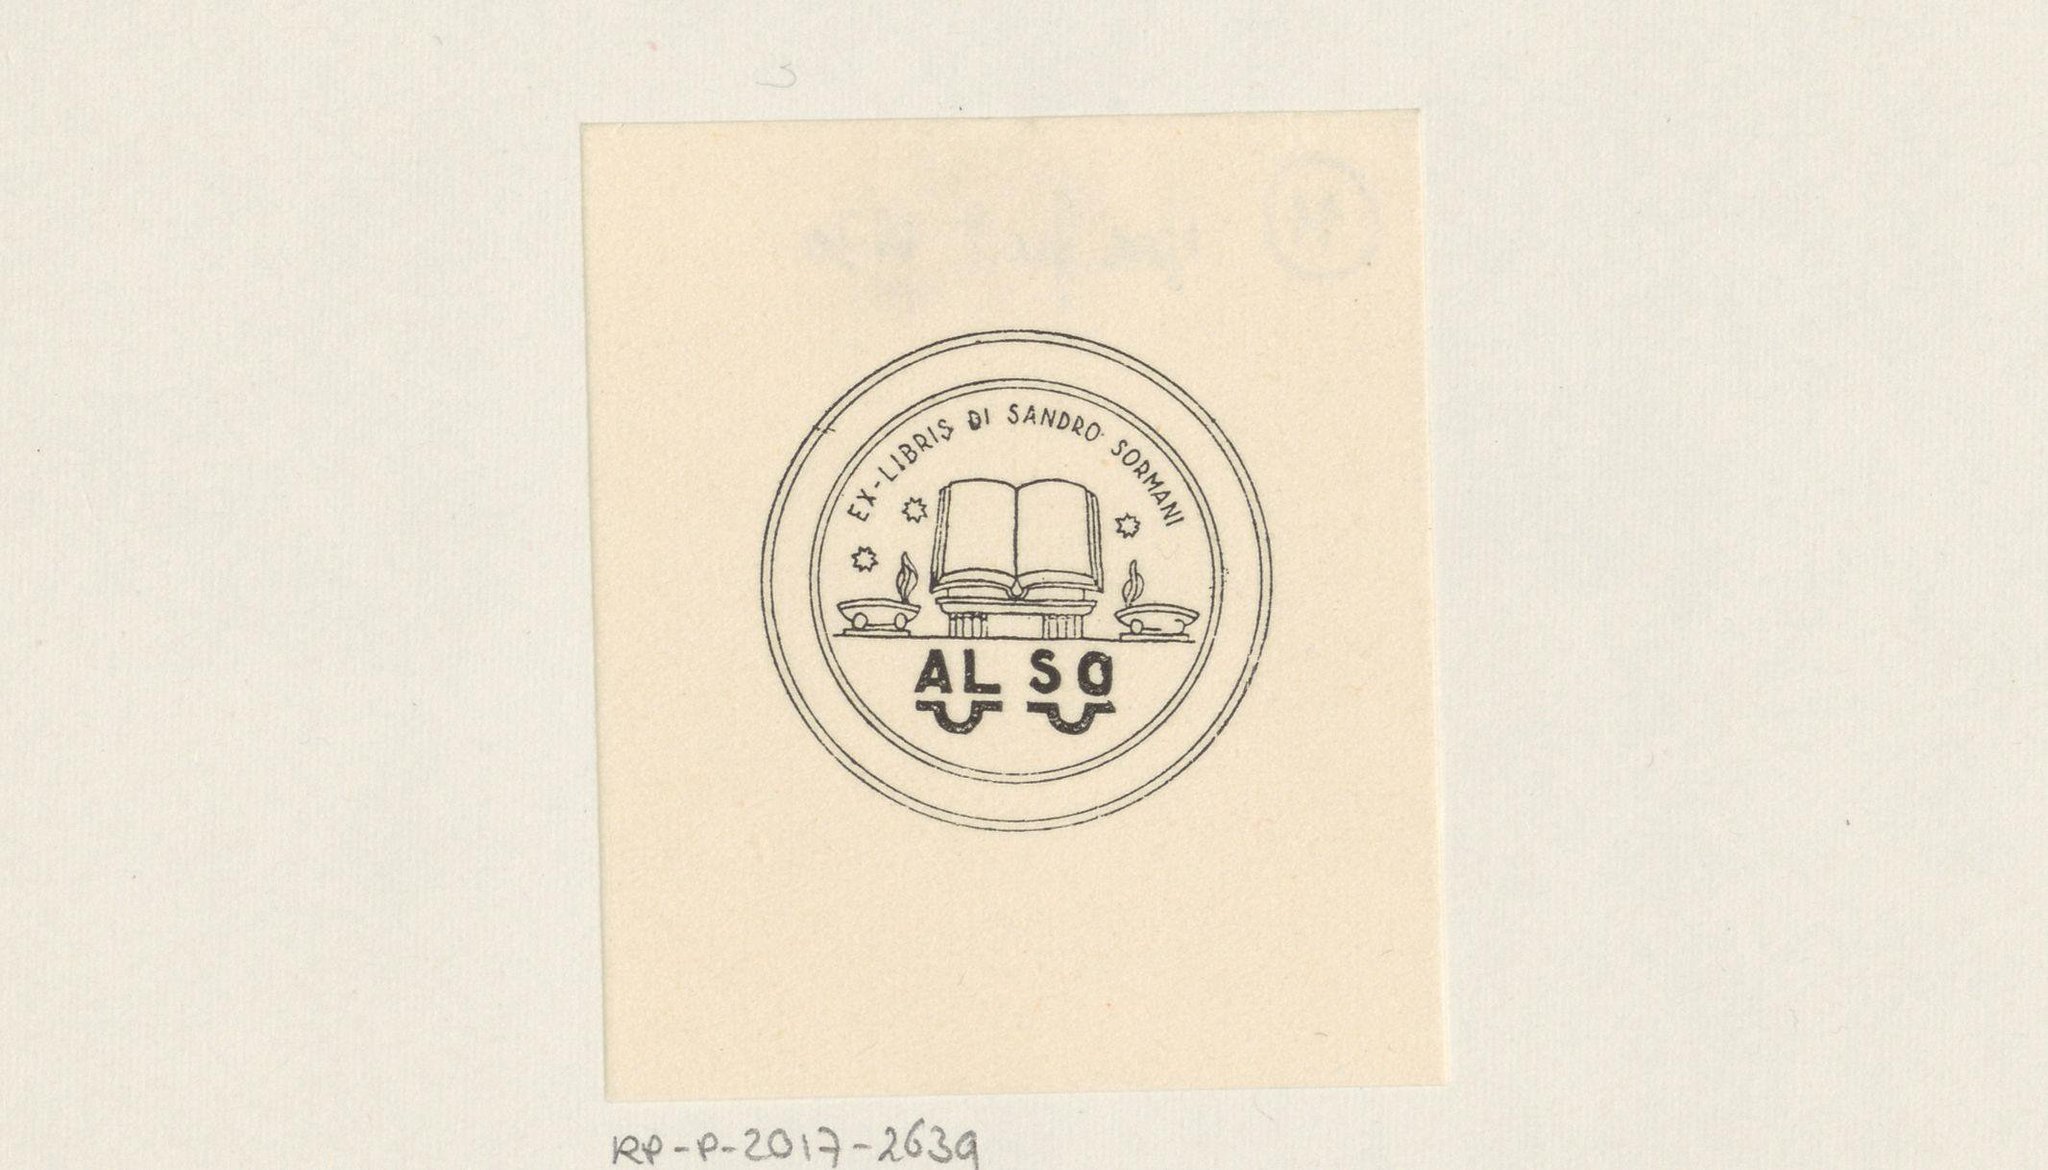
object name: bookplate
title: Ex libris van Sandro Sormani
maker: Anonymous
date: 1930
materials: paper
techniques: printing block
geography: milan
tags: alessandro sormani, book, oil-lamp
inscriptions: inscription: ‘ipse fecit 1930’